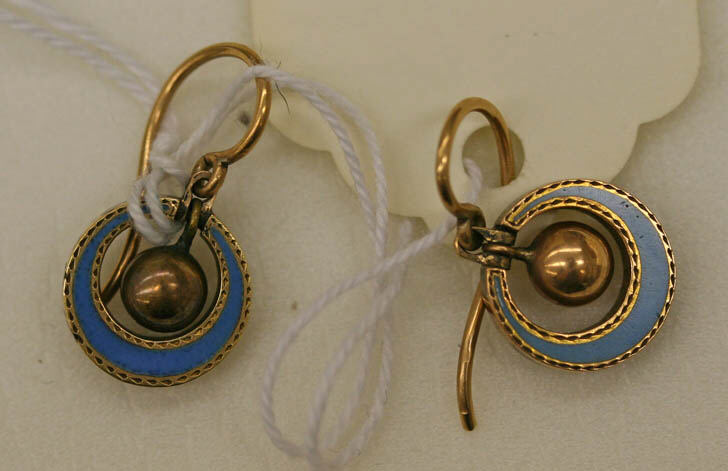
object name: earring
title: Earrings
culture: american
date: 1875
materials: enamel, metal